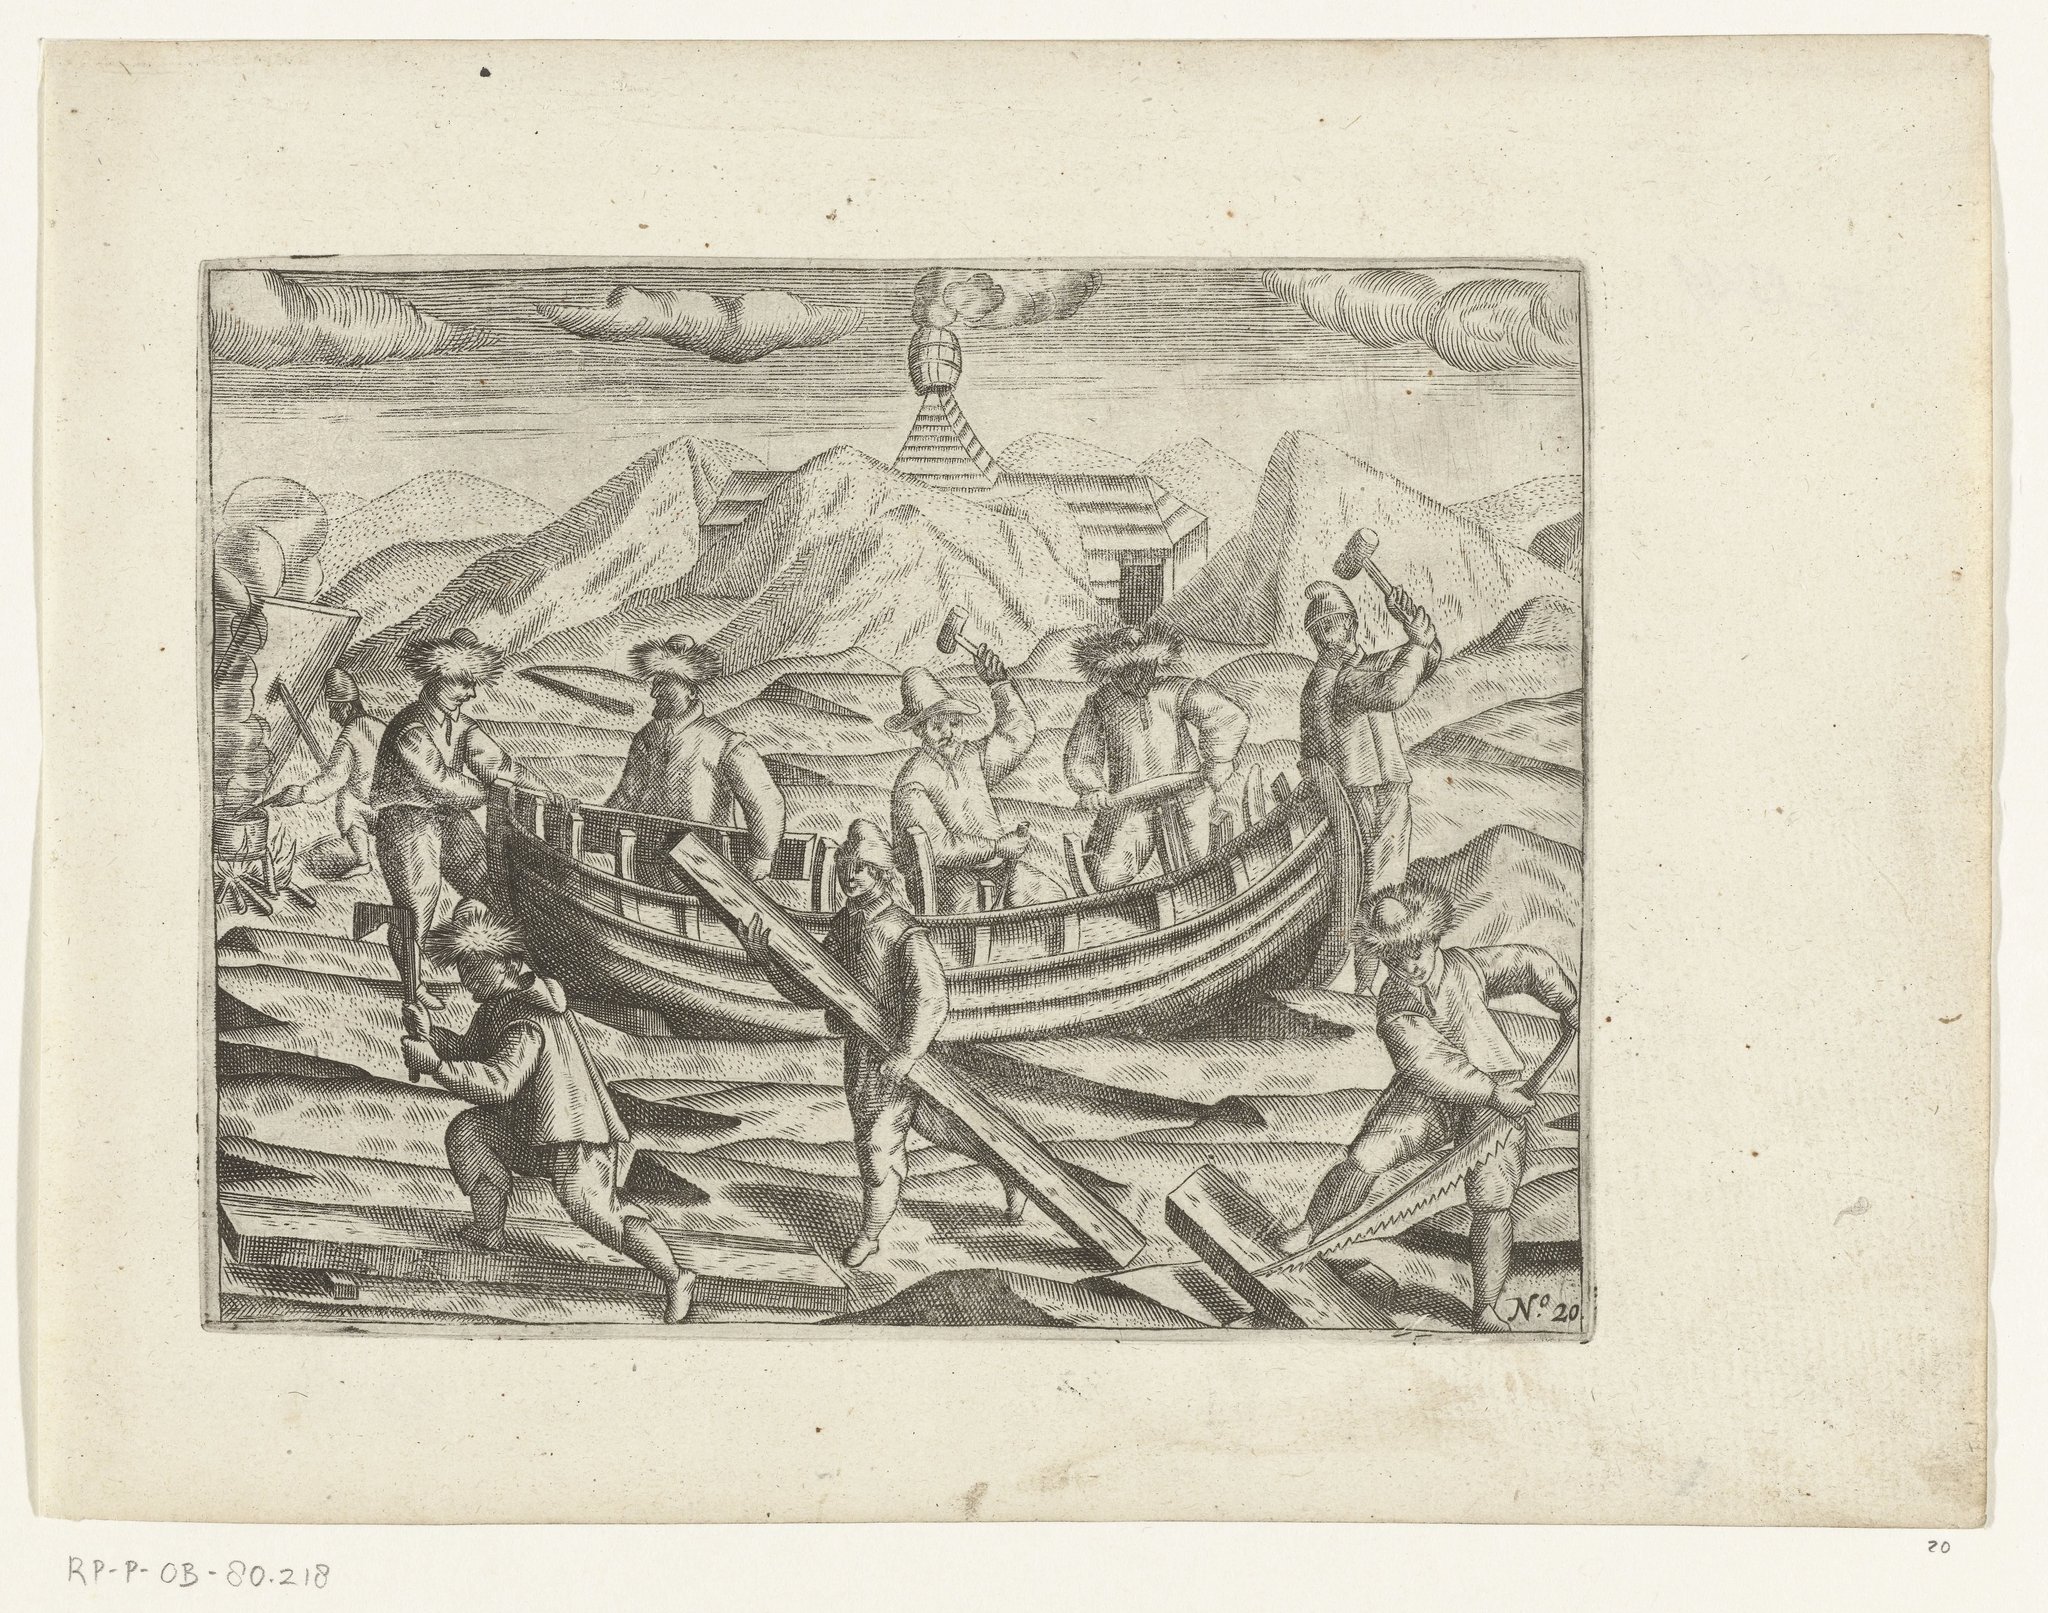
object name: print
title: Timmerwerk aan de sloep, 1597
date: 1615-1617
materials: paper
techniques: engraving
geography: northern netherlands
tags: willem barendsz., amsterdam, jacob van heemskerck, landscapes in polar regions, exploration, expedition, voyage of discovery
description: Gebruikt als illustratie eerst in: G. de Veer, De waerachtige beschrijvinge vande drie seylagien, drie jaren achter mal-kanderen deur de Hollandtsche ende Zeelandtsche Schepen, by noorden Noorweghen, Moscovien ende tartarien nae de Coninckrijcken van Catthay ende China ghedaene, [Michiel Colijn, Amsterdam 1617]. Later gebruikt in: Kort verhael van d'eerste Schipvaerd der Hollandsche ende Zeeusche Schepen by noorden Noorwegen, Moscovien ende Tartarien om, nae de Coningrijcken van Cathay ende China, getogen uyt het Journael van Gerrit de Veer. Opgenomen in: I. Commelin, Begin ende voortgangh, van de Vereenighde Nederlantsche Geoctroyeerde Oost-Indische Compagnie, J. Janssonius, Amsterdam 1646. Genummerd: No. 20.